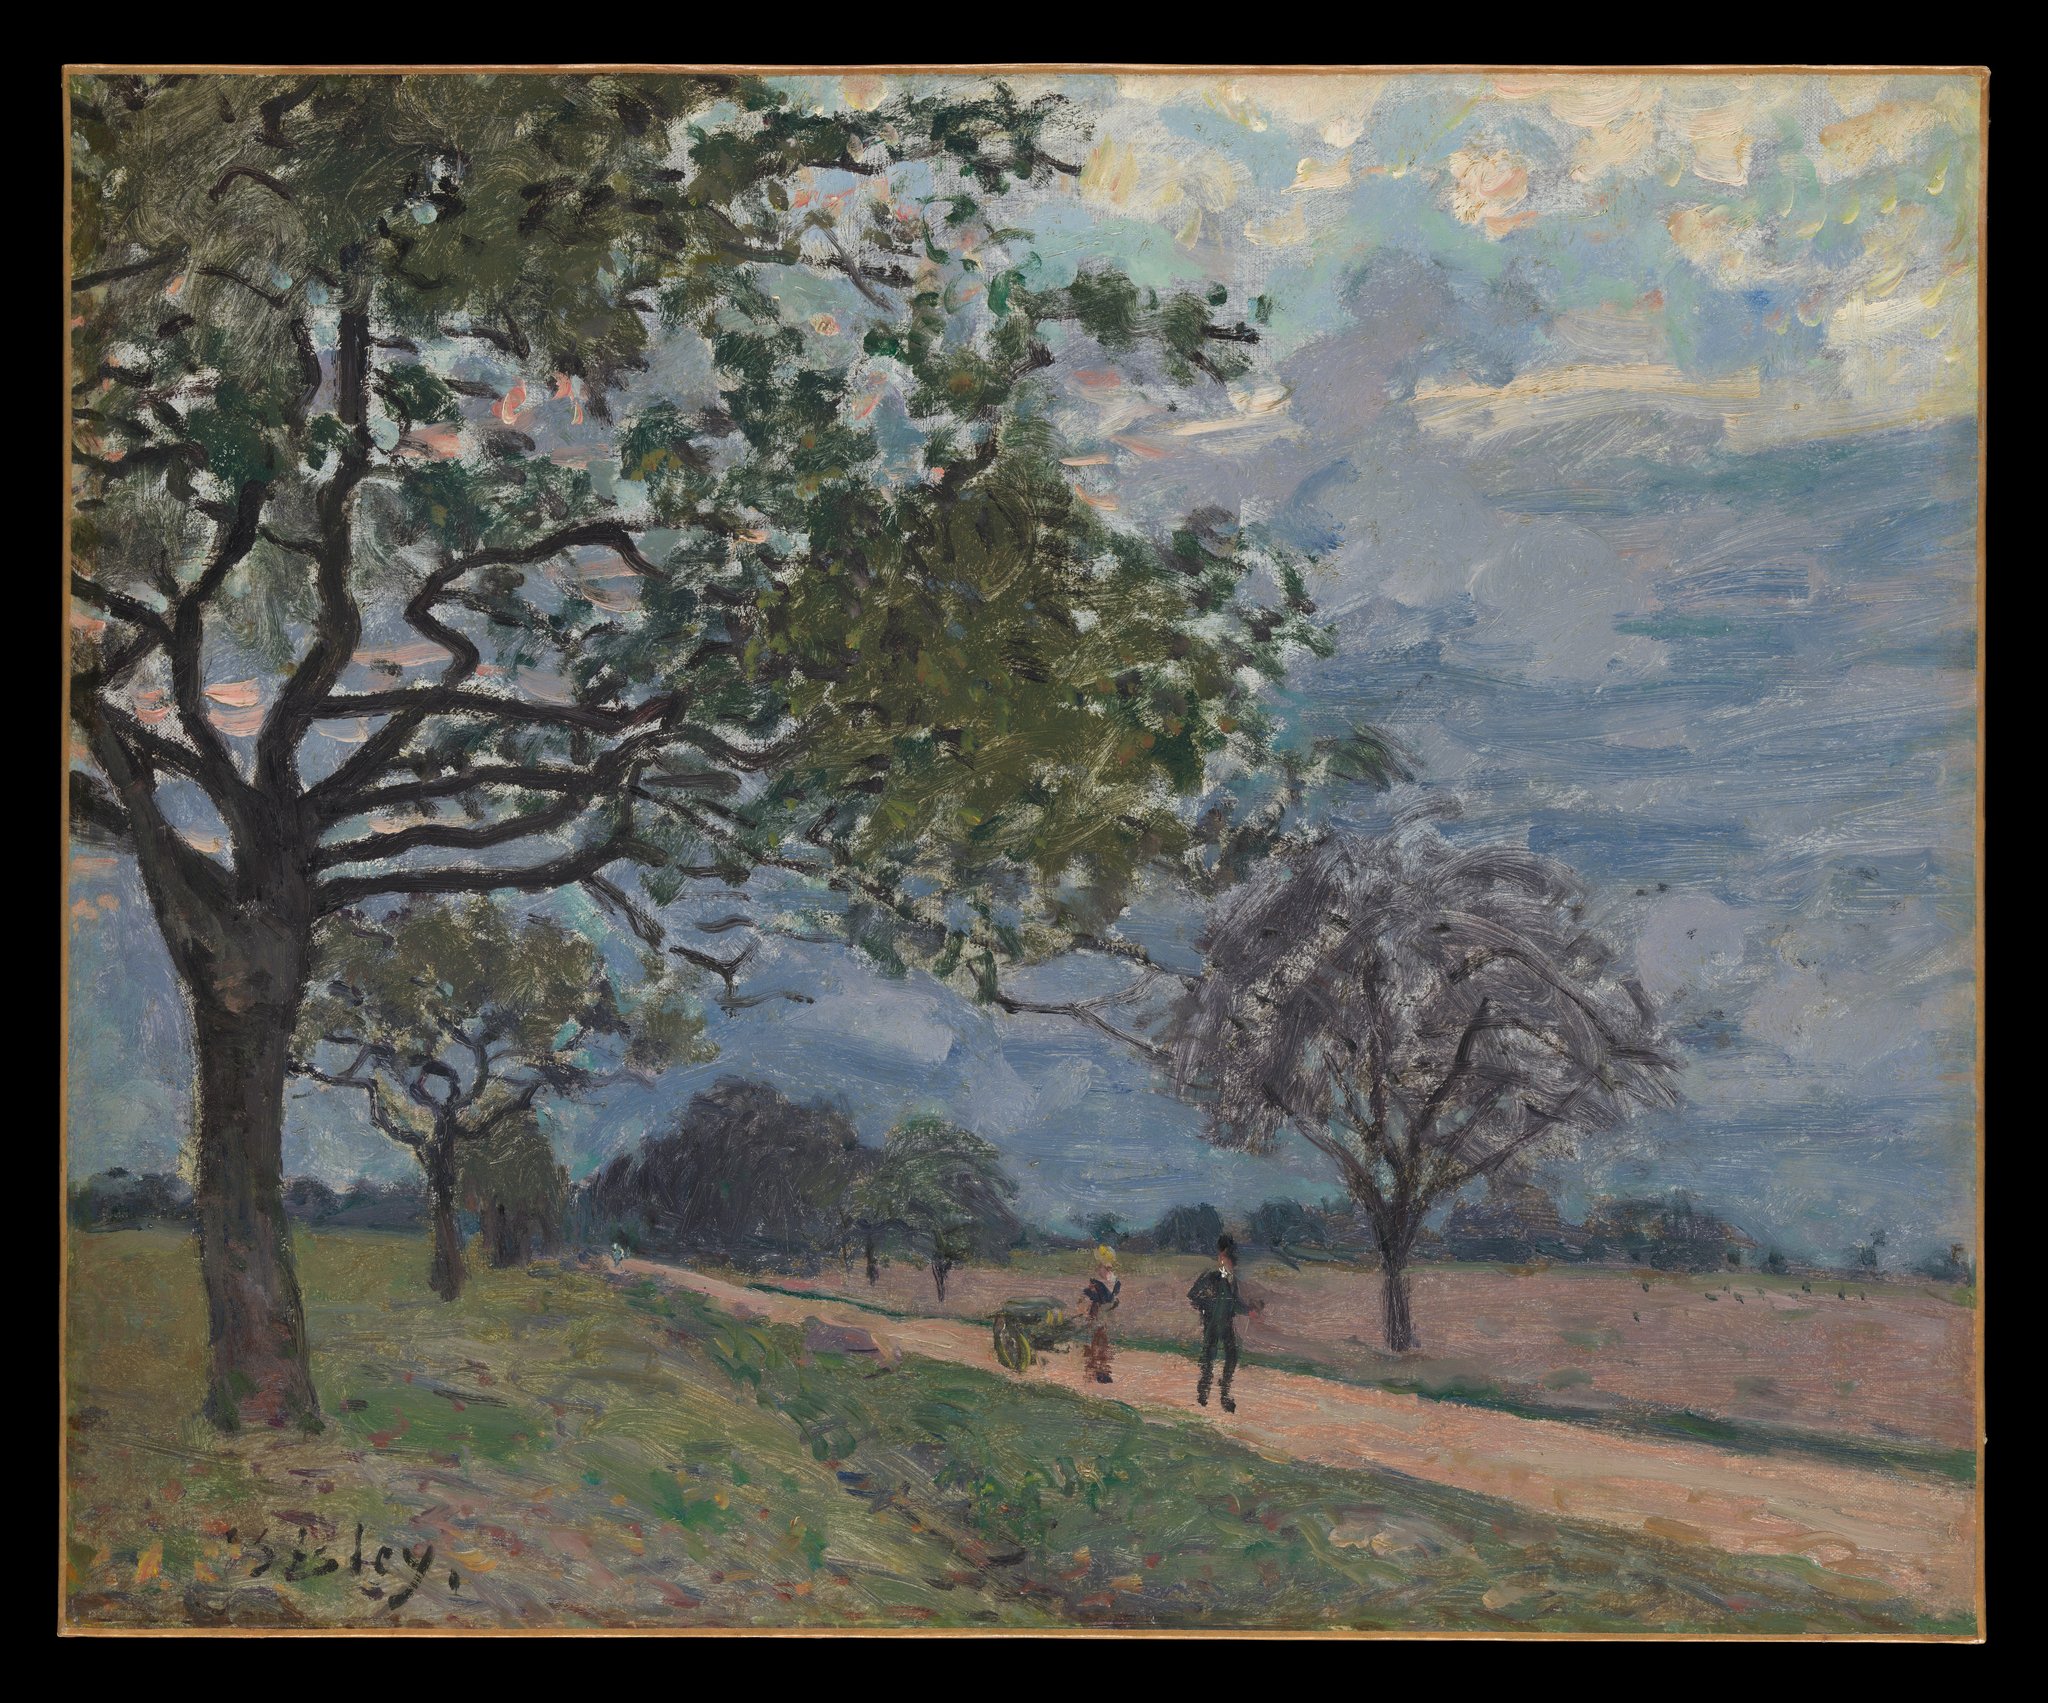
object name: painting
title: The Road from Versailles to Louveciennes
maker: alfred sisley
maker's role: artist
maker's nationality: british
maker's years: 1839-1899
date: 1879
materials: canvas, oil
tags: roads,landscapes